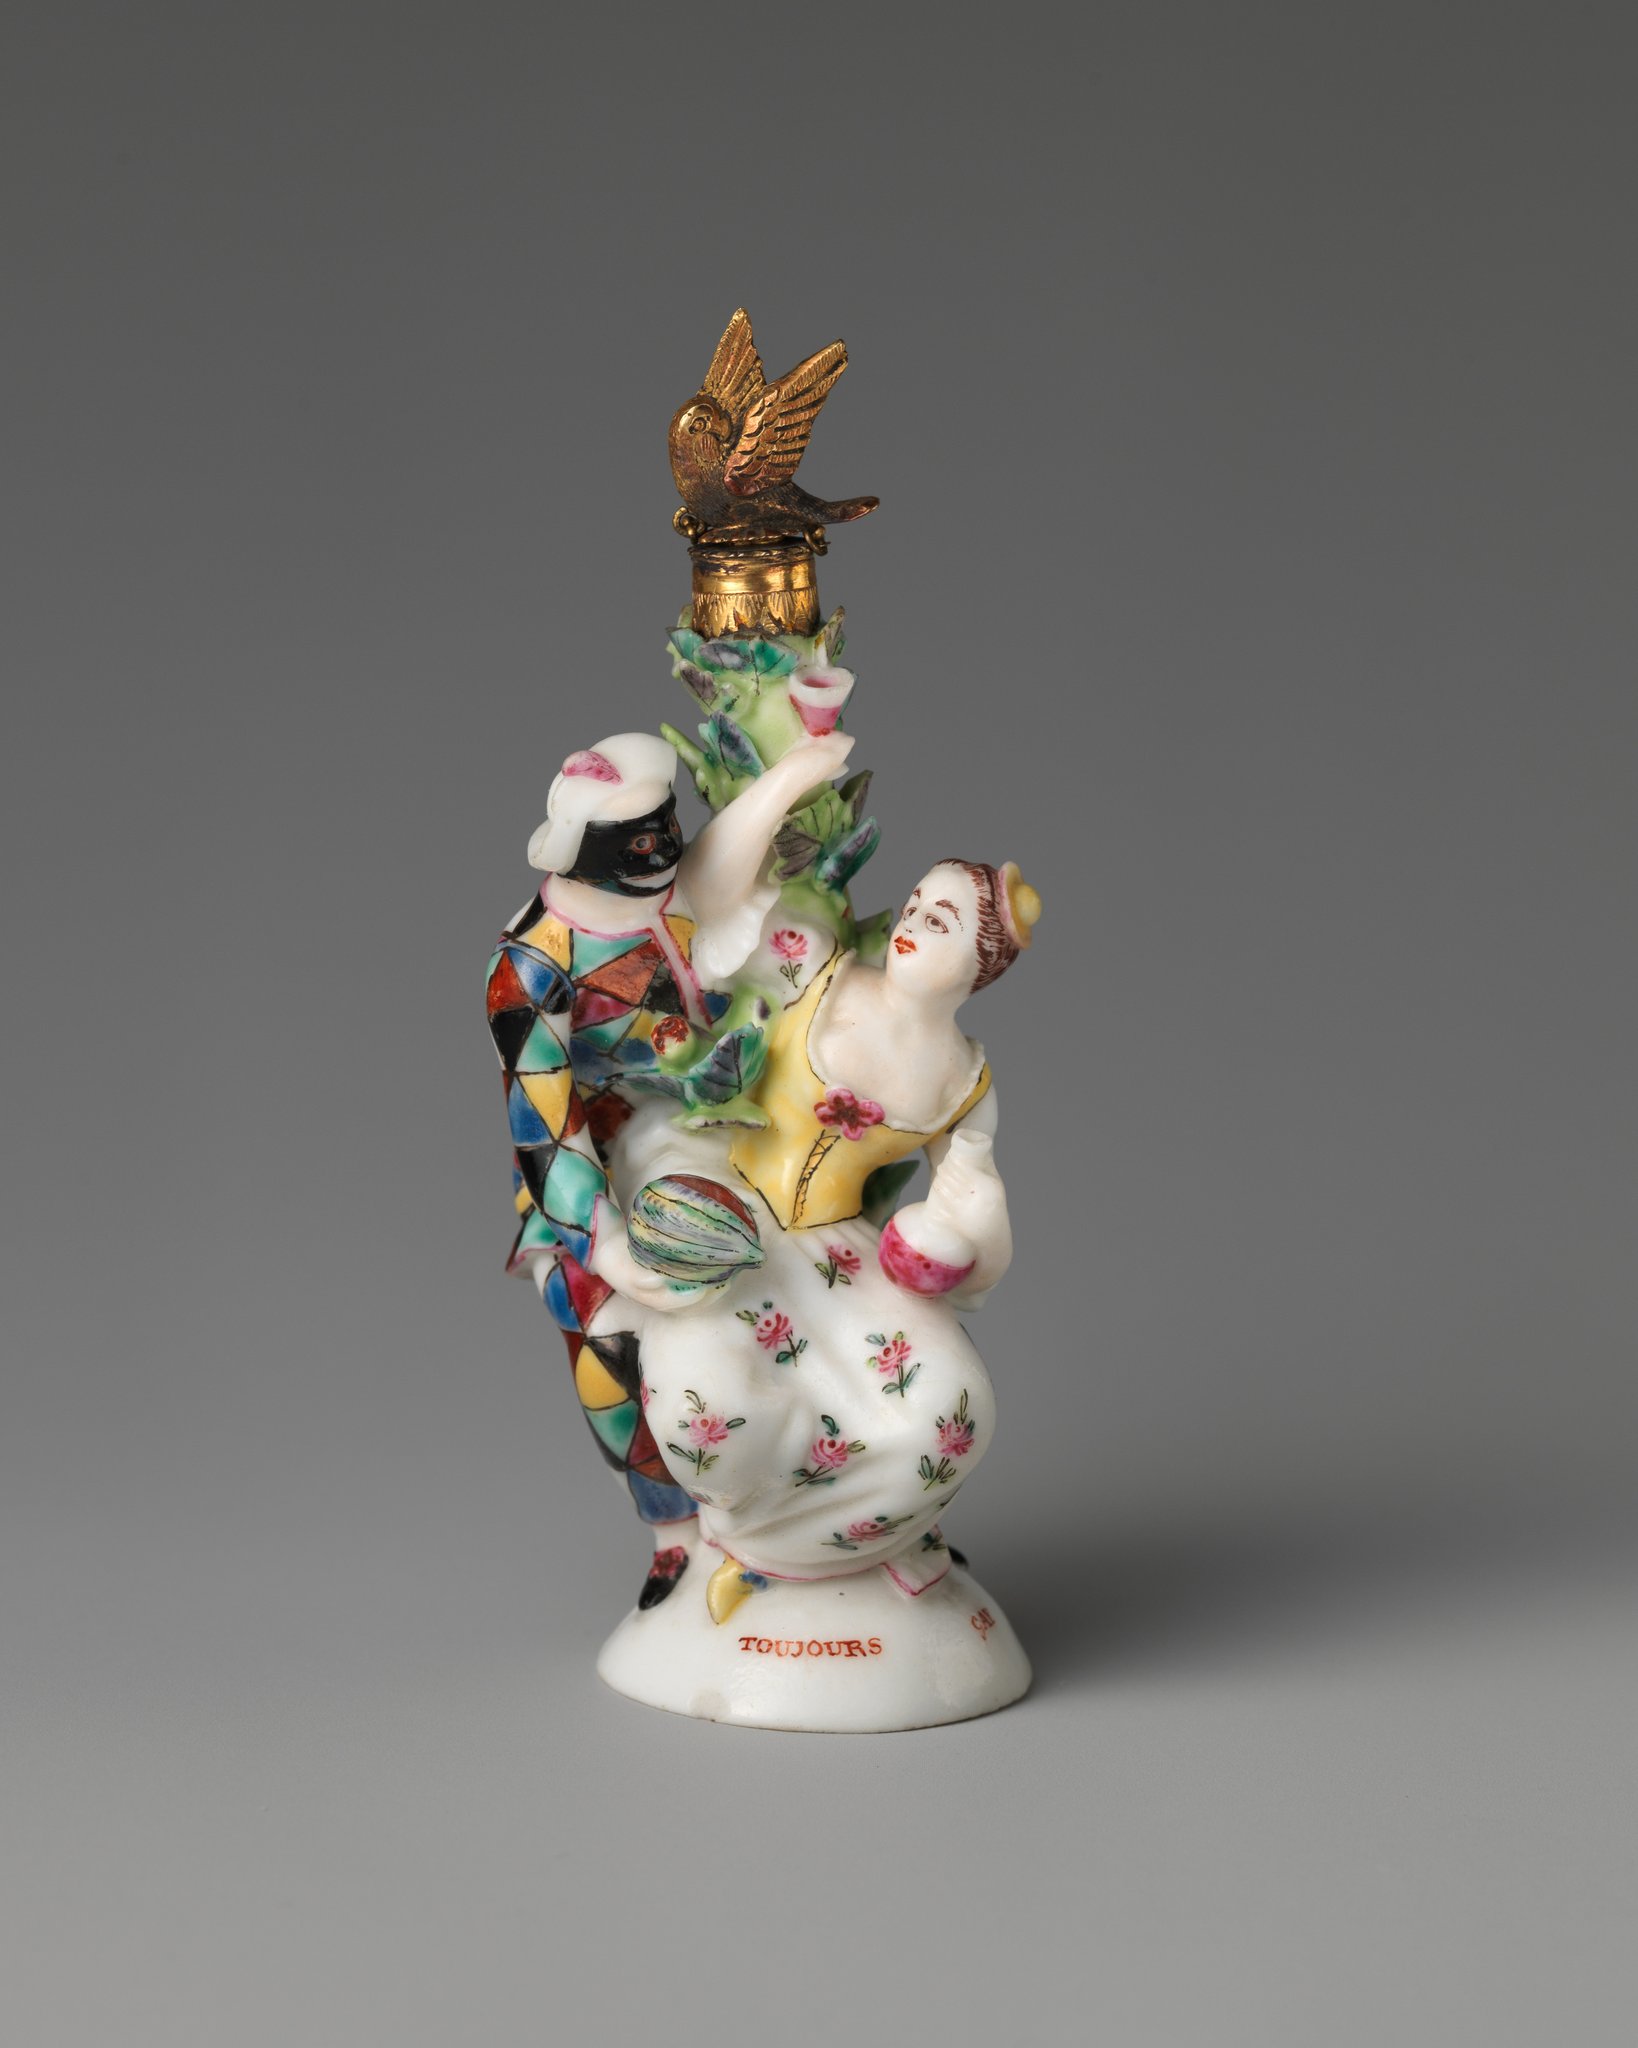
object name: toy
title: Harlequin and Columbine in a group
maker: saint james's factory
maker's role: maker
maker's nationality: british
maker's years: 1749-1759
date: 1750-1755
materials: soft paste porcelain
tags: birds,men,women,flowers,clowns